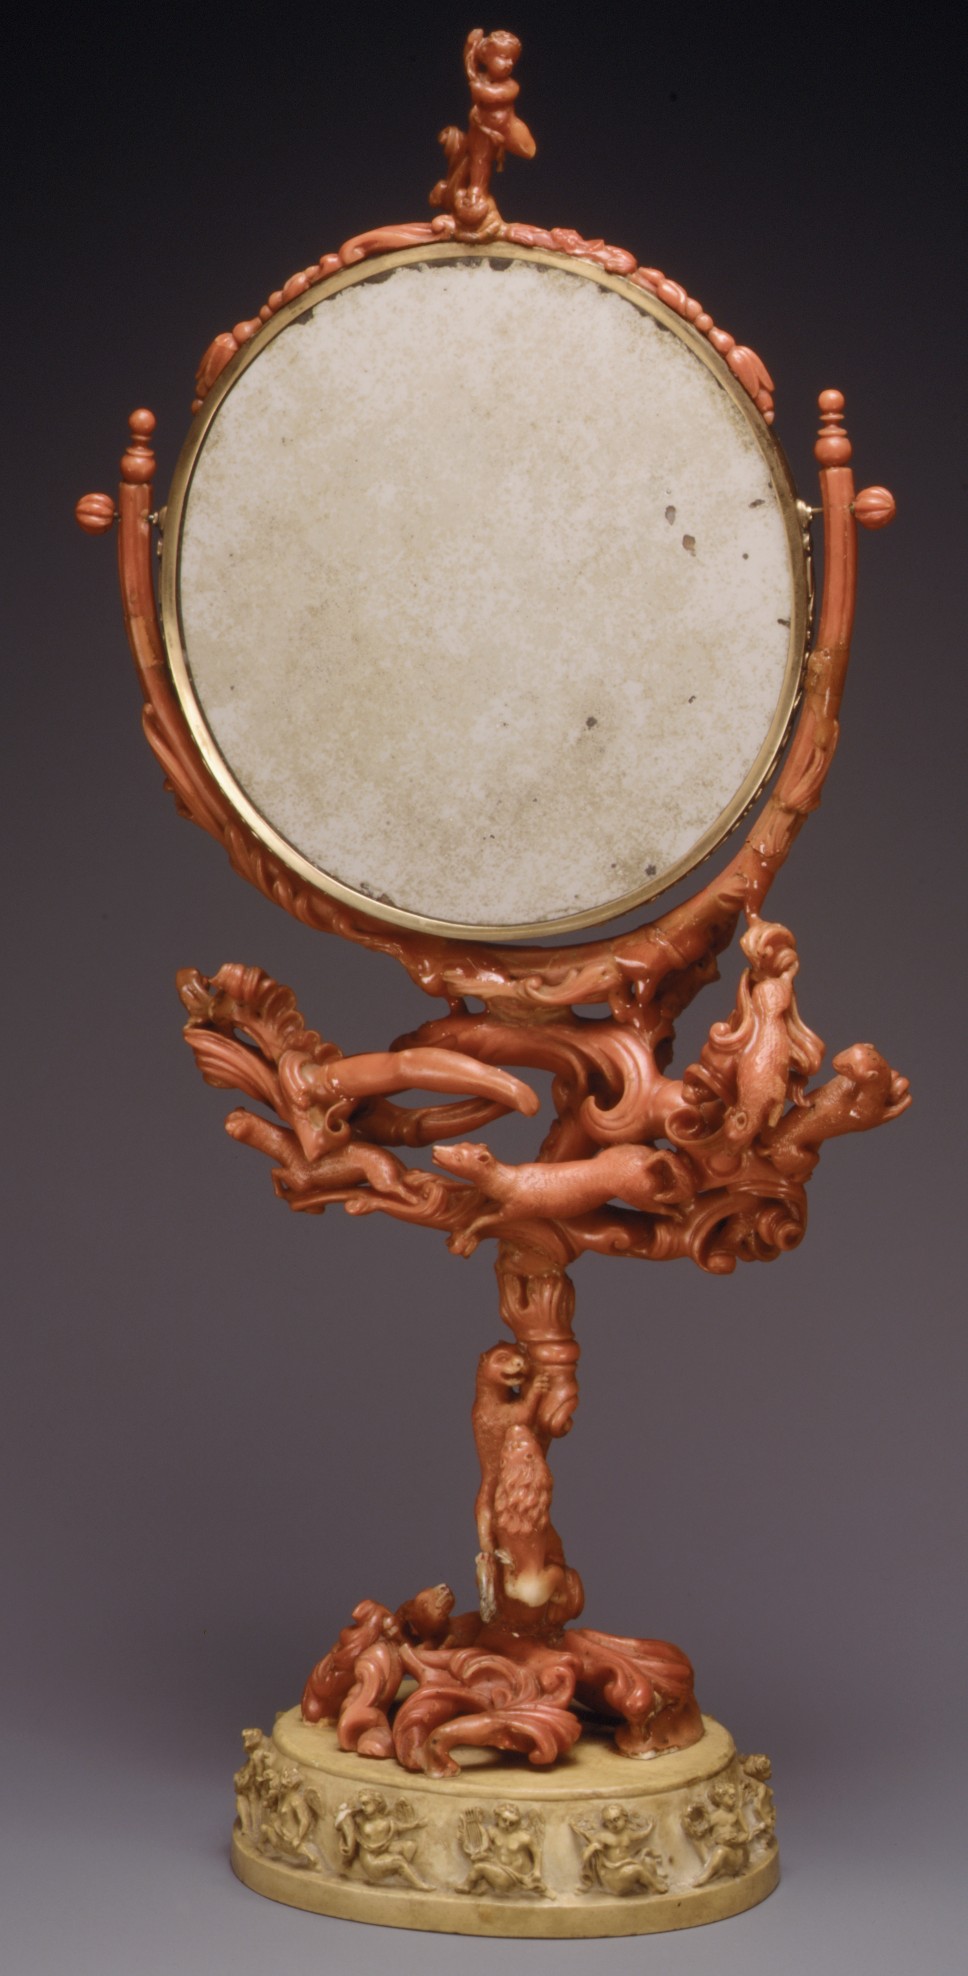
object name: mirror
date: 1701-1800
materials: brass, coral, gilt, glass